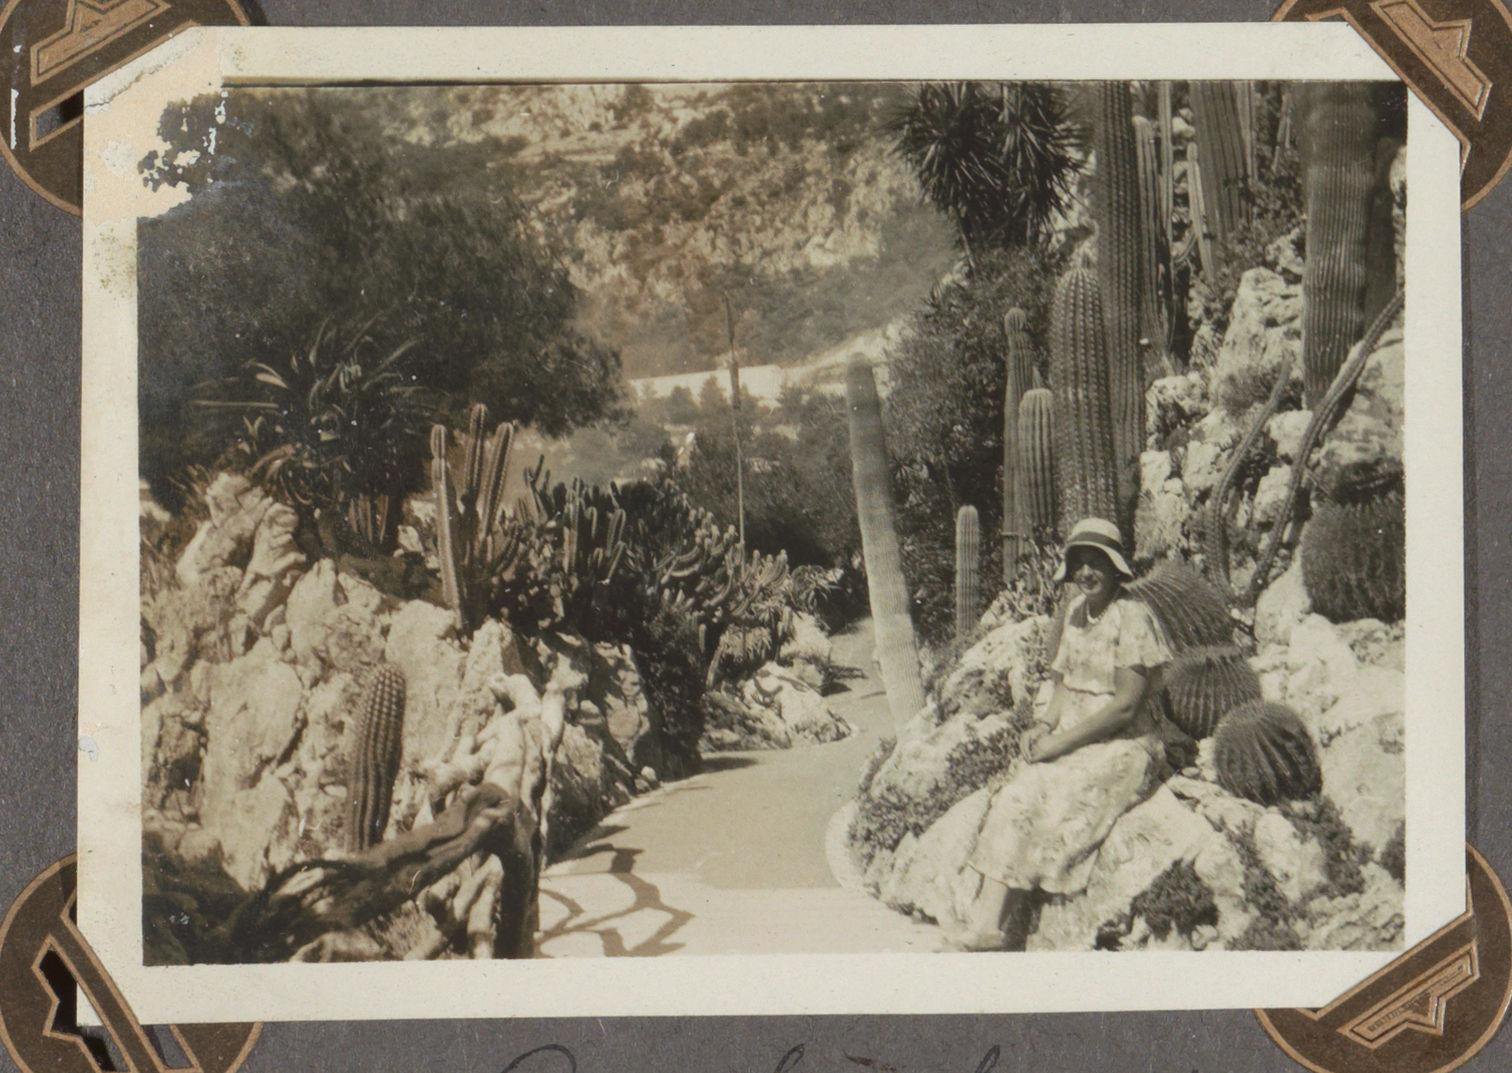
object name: photograph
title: Vrouw zittend in de cactustuin van Monte-Carlo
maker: Anonymous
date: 1930-1935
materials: photographic support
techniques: gelatin silver print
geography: monte carlo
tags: adult woman, public gardens, park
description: Onderdeel van Fotoalbum met opnames van vakanties in Zuid-Frankrijk.